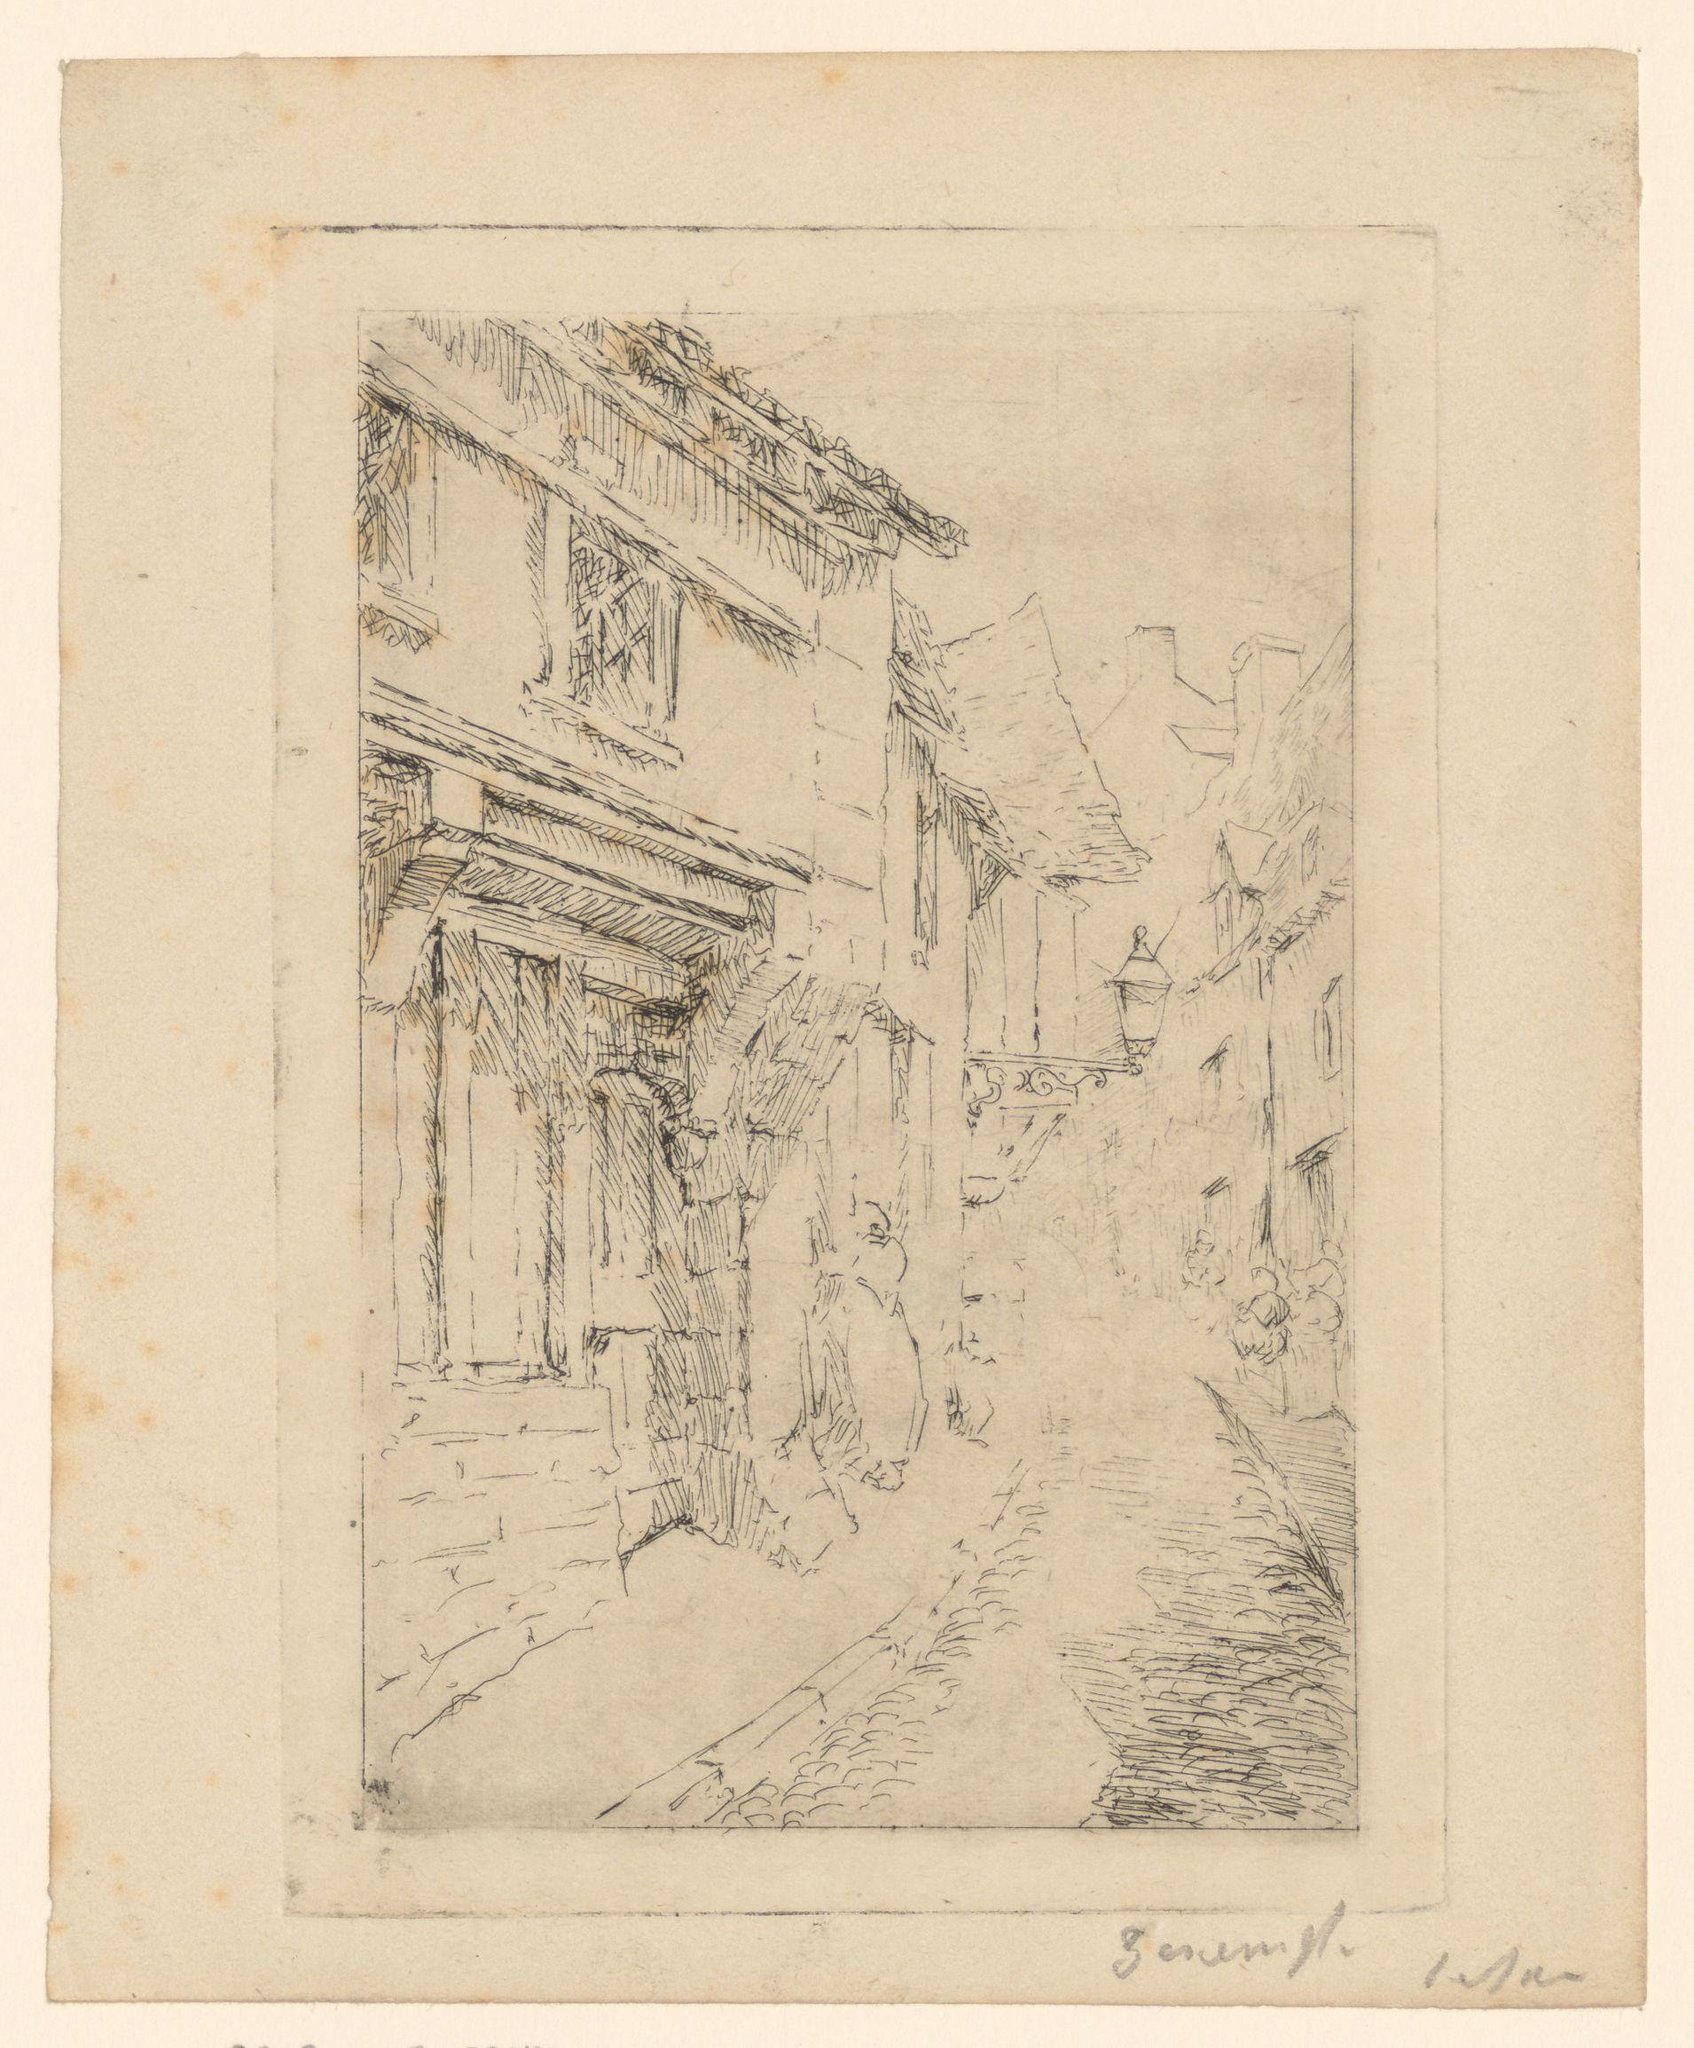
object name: print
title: Straat in bergdorp met uithangende lantaarn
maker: william spread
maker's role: print maker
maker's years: 1846-1909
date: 1879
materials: paper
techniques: etching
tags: lantern, street (+ city(-scape) with figures, staffage)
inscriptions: collector's mark: Lugt 2228